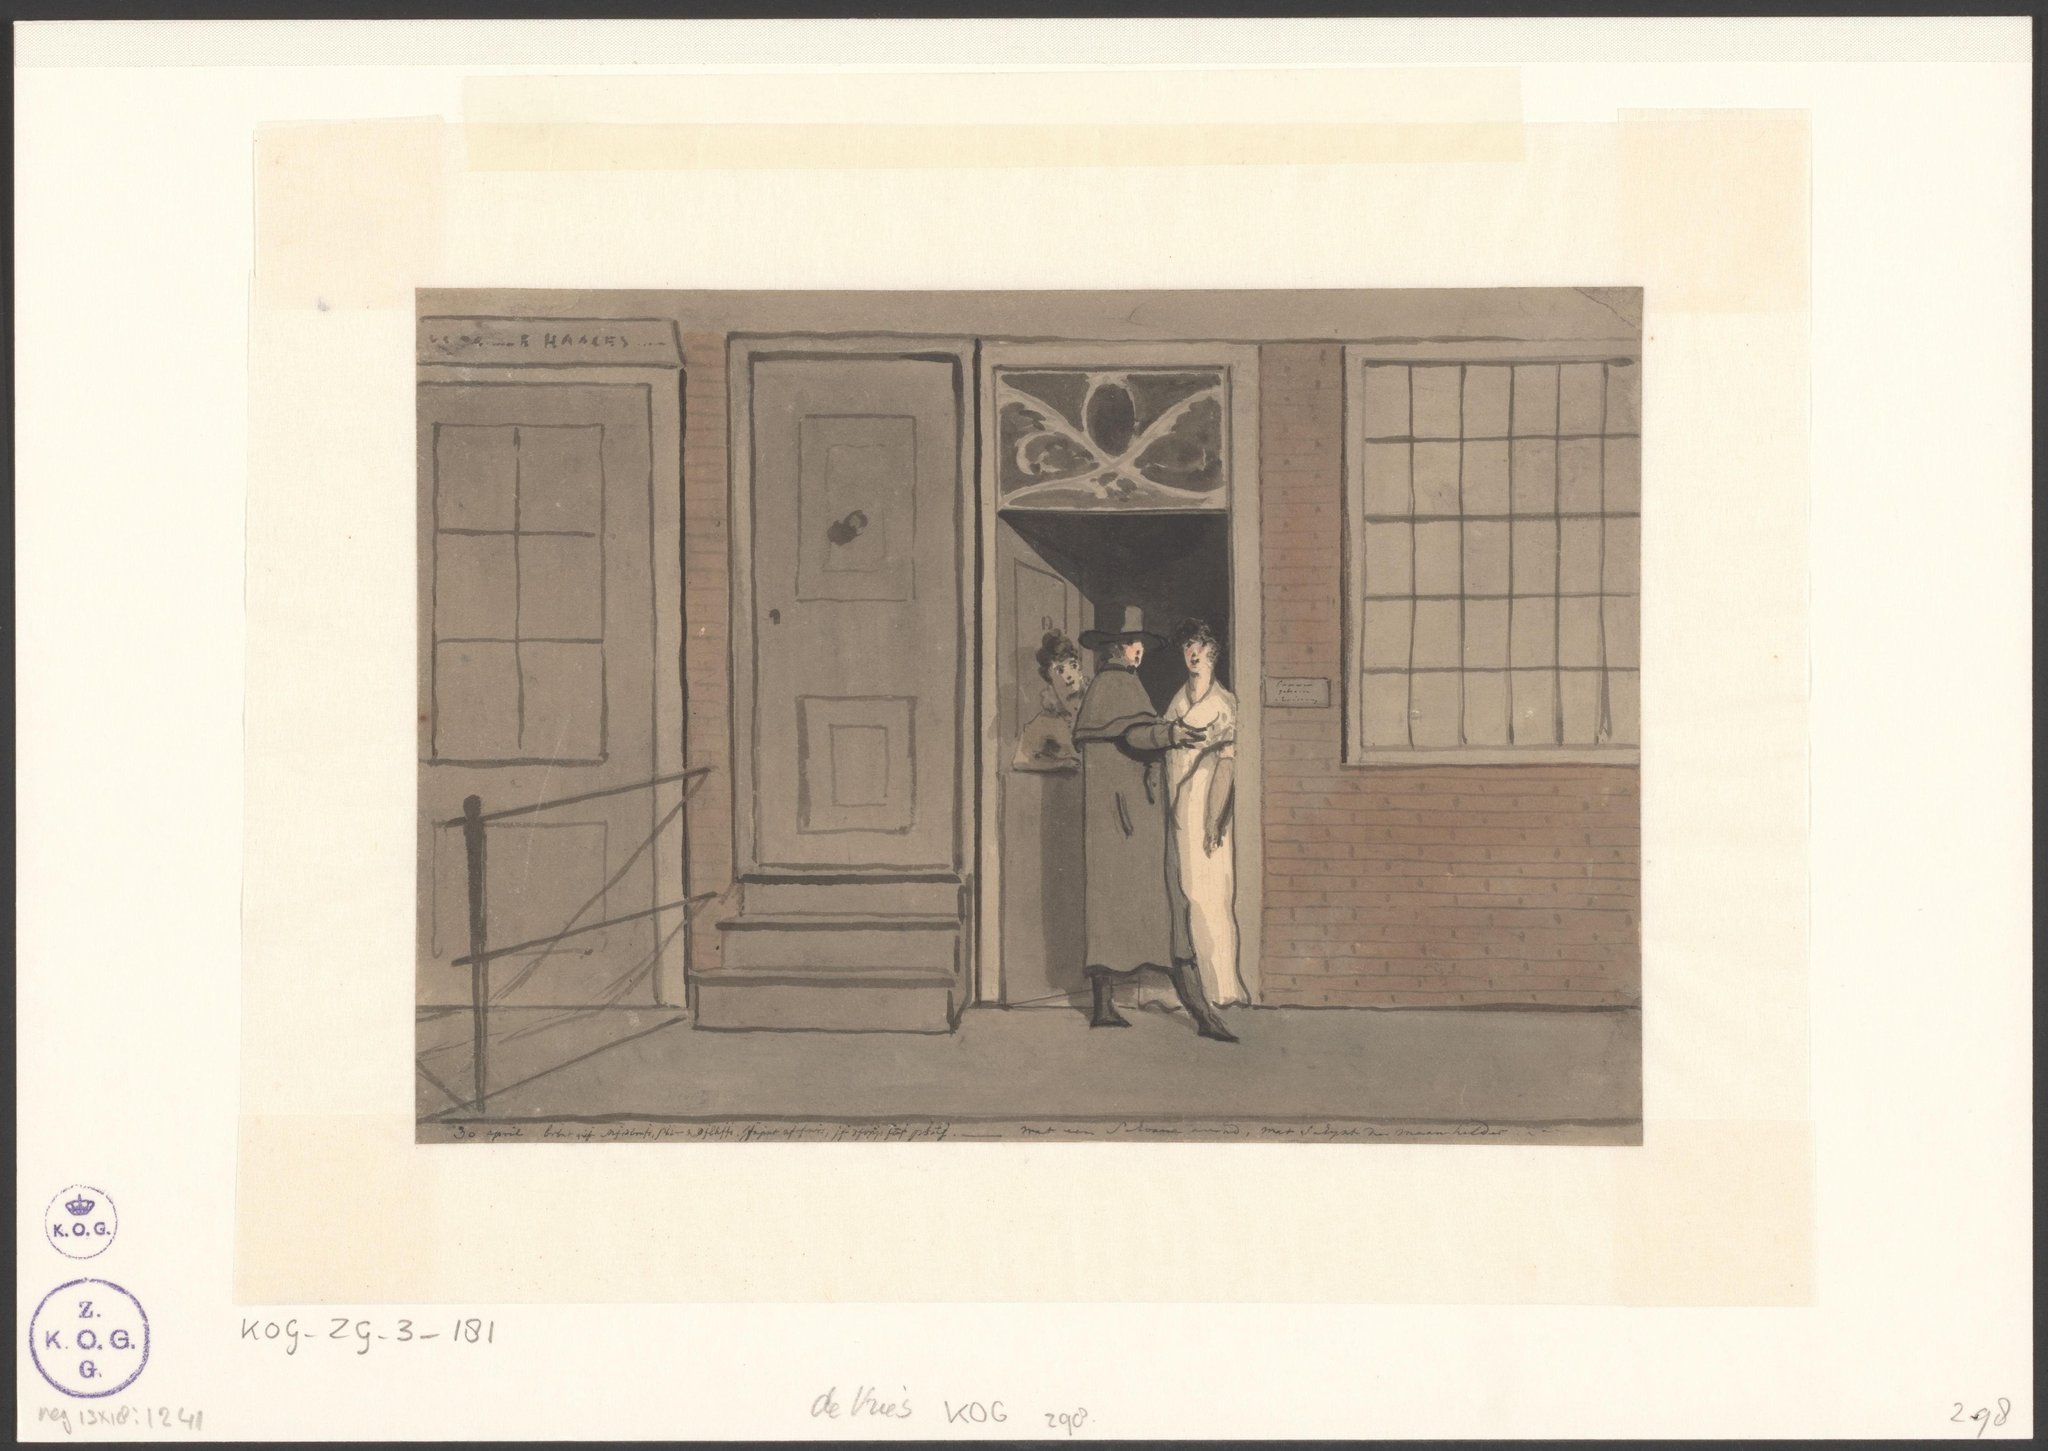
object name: drawing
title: Christiaan Andriessen in gesprek met twee dames in de deuropening van hun huis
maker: christiaan andriessen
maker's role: draughtsman, print maker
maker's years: 1775-1846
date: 1804-1806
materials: ink, paper, pencil, watercolor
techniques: brush, pen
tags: print maker, draughtsman, christiaan andriessen, open door, conversation, dialogue; conversation piece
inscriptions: collector's mark: Lugt 1641a, signature: ‘J Andriessen’, inscription: ‘30 april wat een schoone avond, wat schijnt de maan helder’, collector's mark: Lugt 1641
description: Dagboekblad uit het getekende dagboek dat Christiaan Andriessen bijhield van 1805 tot en met 1808.